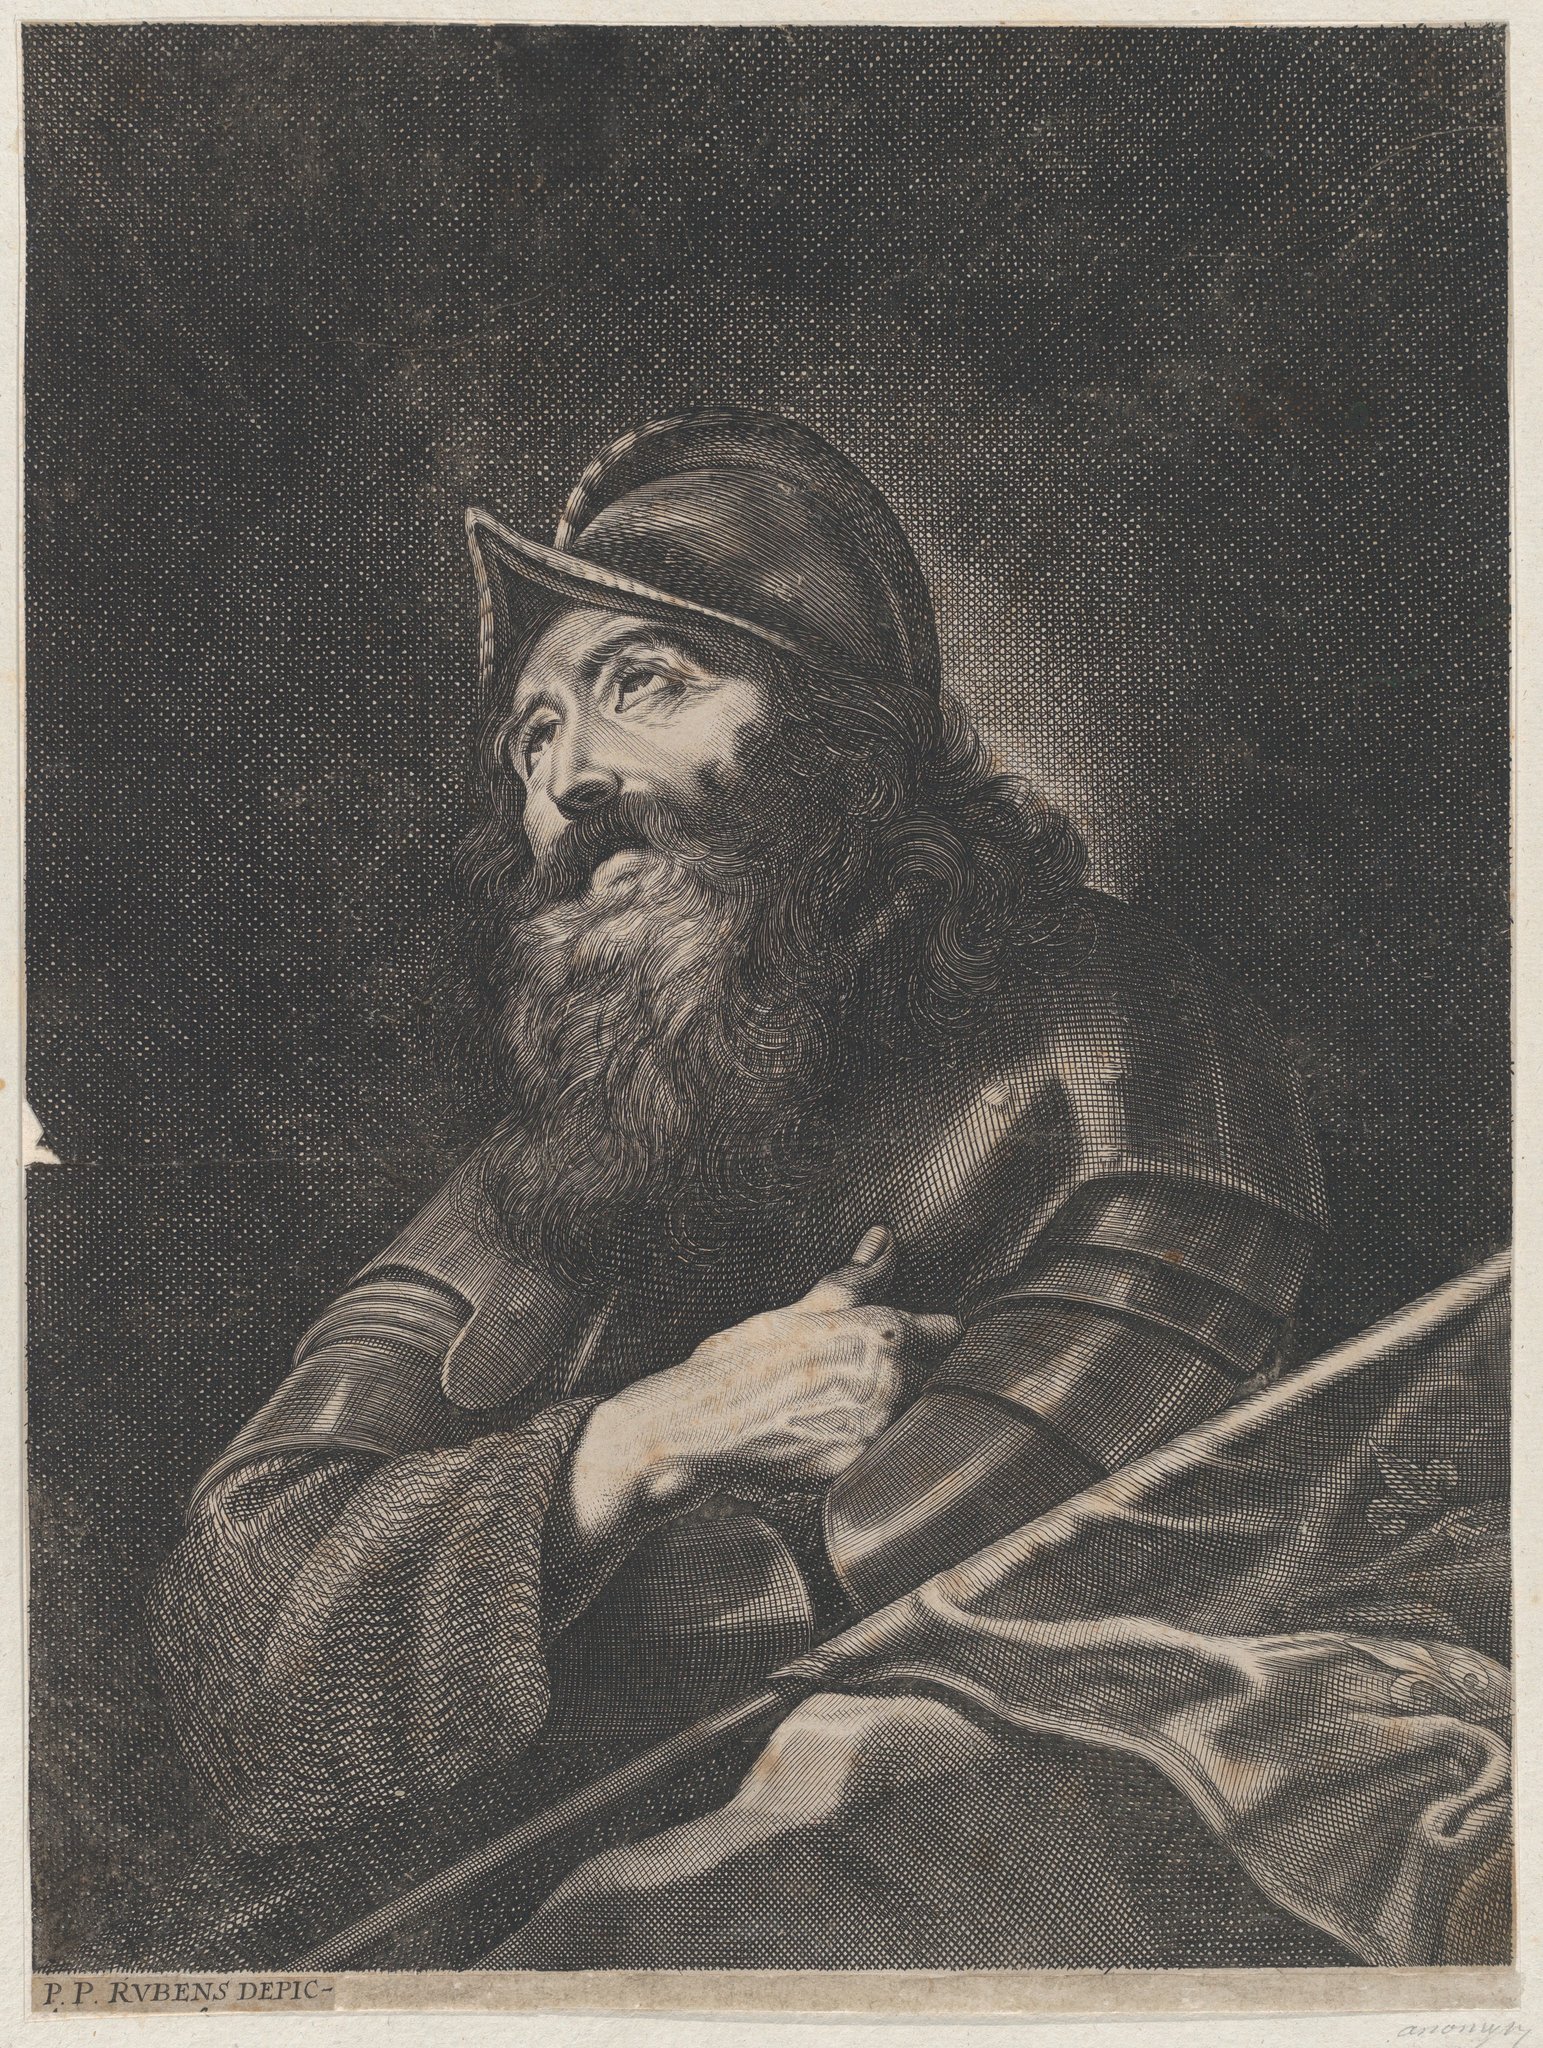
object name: print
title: Saint William of Aquitaine (?)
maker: Anonymous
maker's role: artist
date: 1701-1800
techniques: engraving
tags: portraits,saints